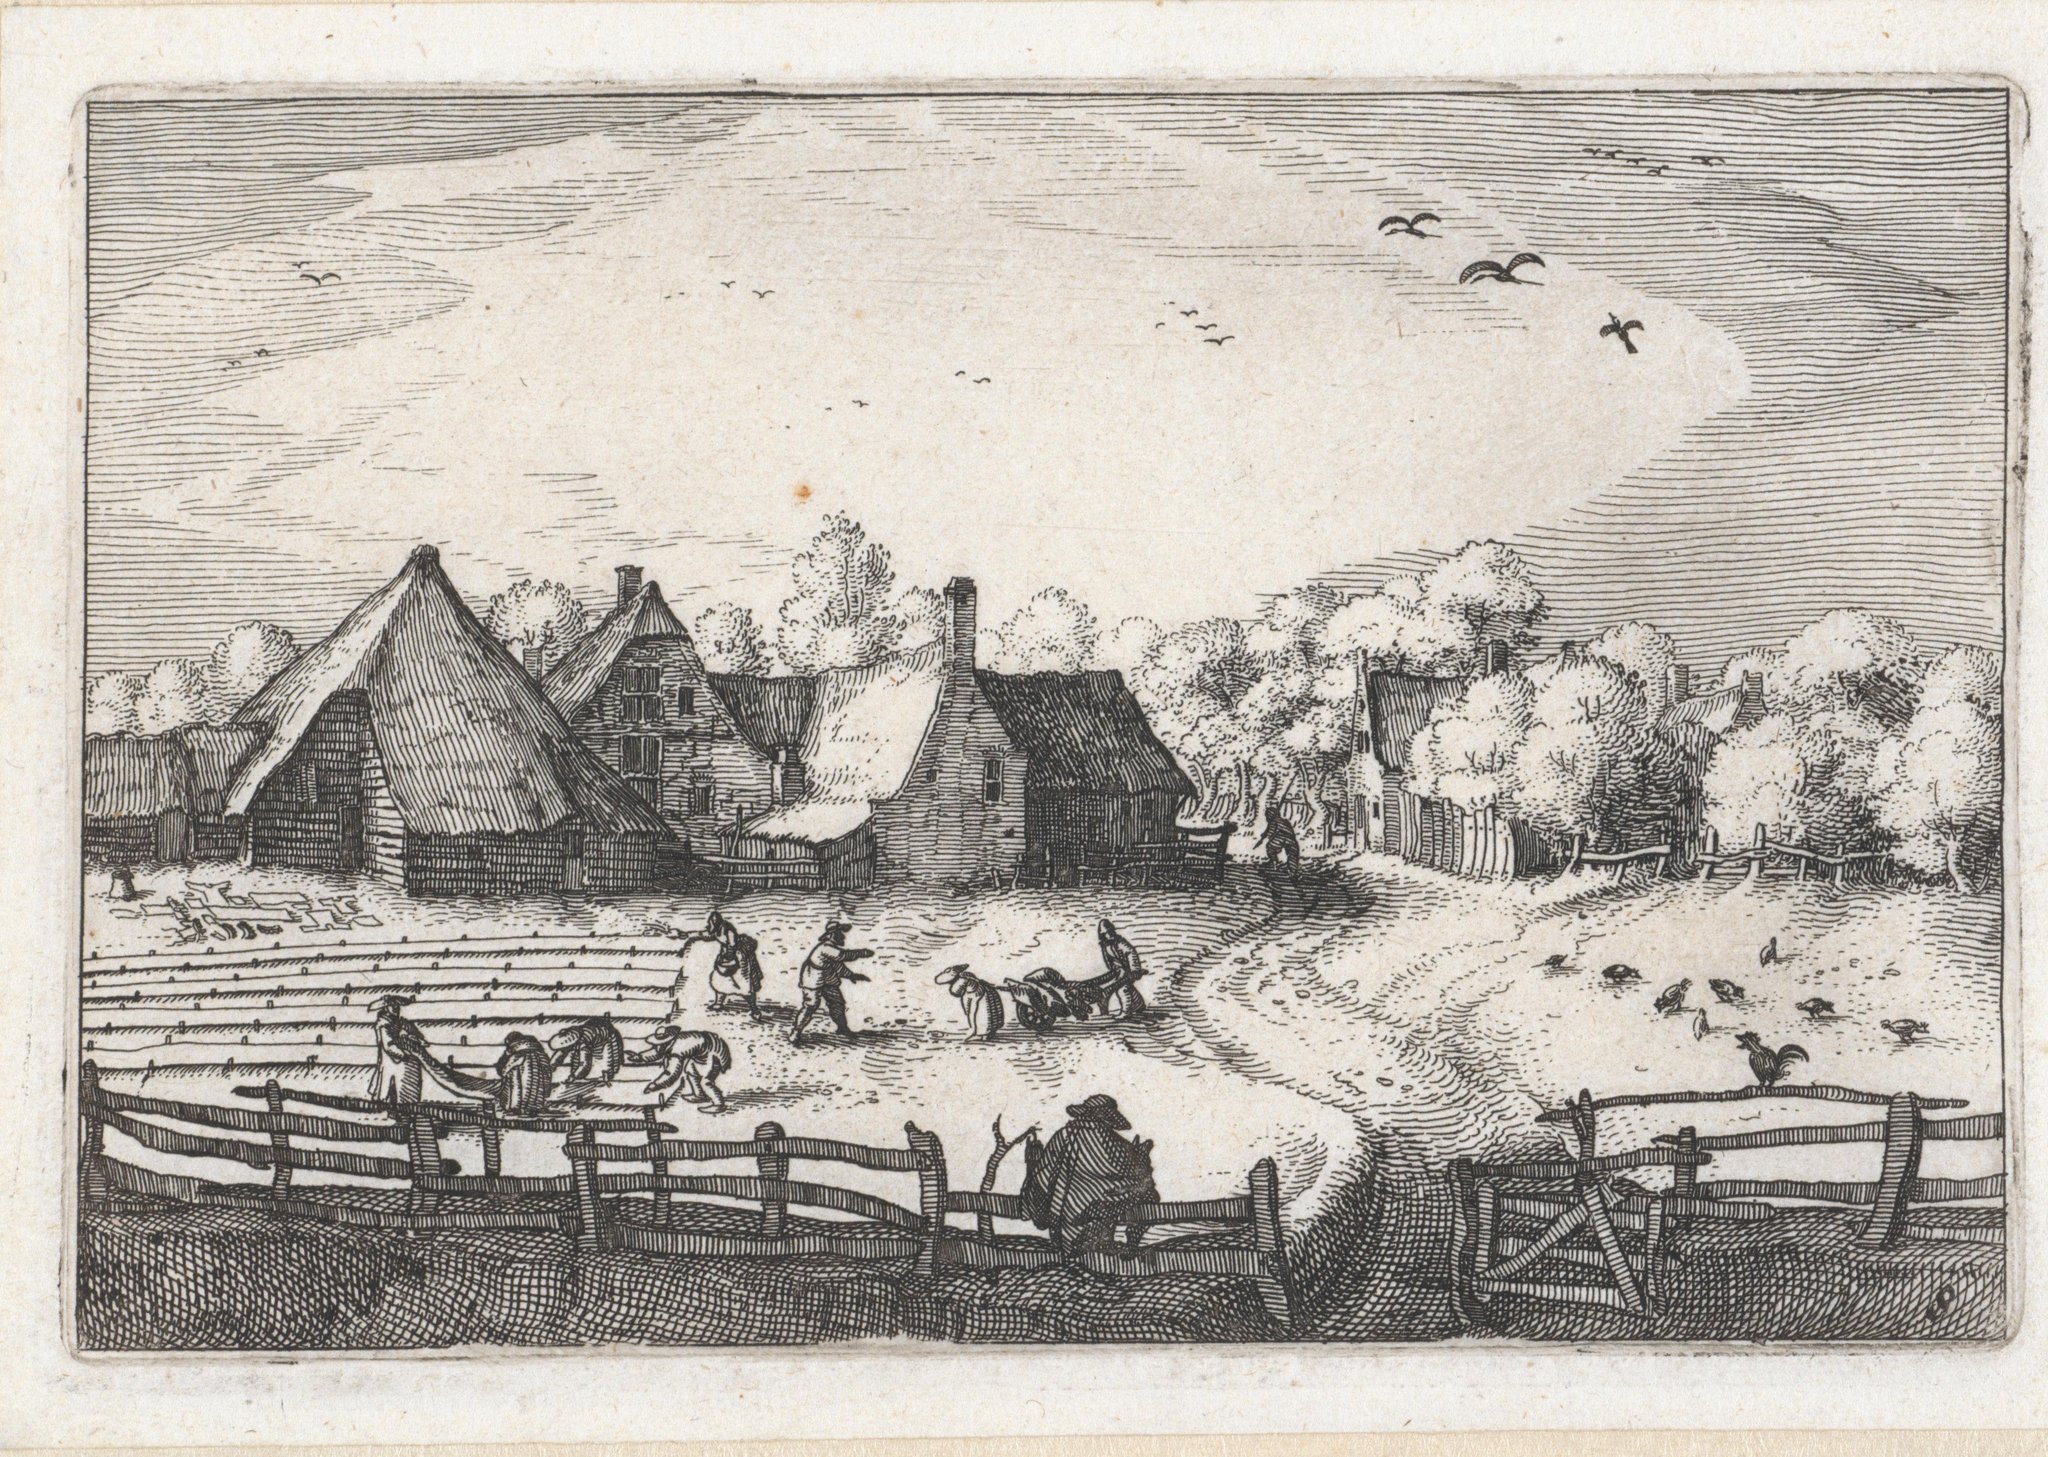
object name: print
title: Gezichten bij Haarlem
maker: claes jansz. visscher (ii)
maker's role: draughtsman, print maker, publisher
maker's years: 1586-1652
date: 1612-1652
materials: paper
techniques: etching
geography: amsterdam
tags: bleaching of yarn, bleaching (laundering), fowl (cock, hen, chicken, etc.), farm (building)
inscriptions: collector's mark: Lugt 2228, number: ‘8’ Lugt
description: Gezicht op de bleekvelden bij de Haarlemmerhout. Achter een lage omheing wordt het linnen op grasvelden te bleken gelegd. Links op de achtergrond een groep boerderijen. Deze prent maakt deel uit van de serie 'Gezichten bij Haarlem'.